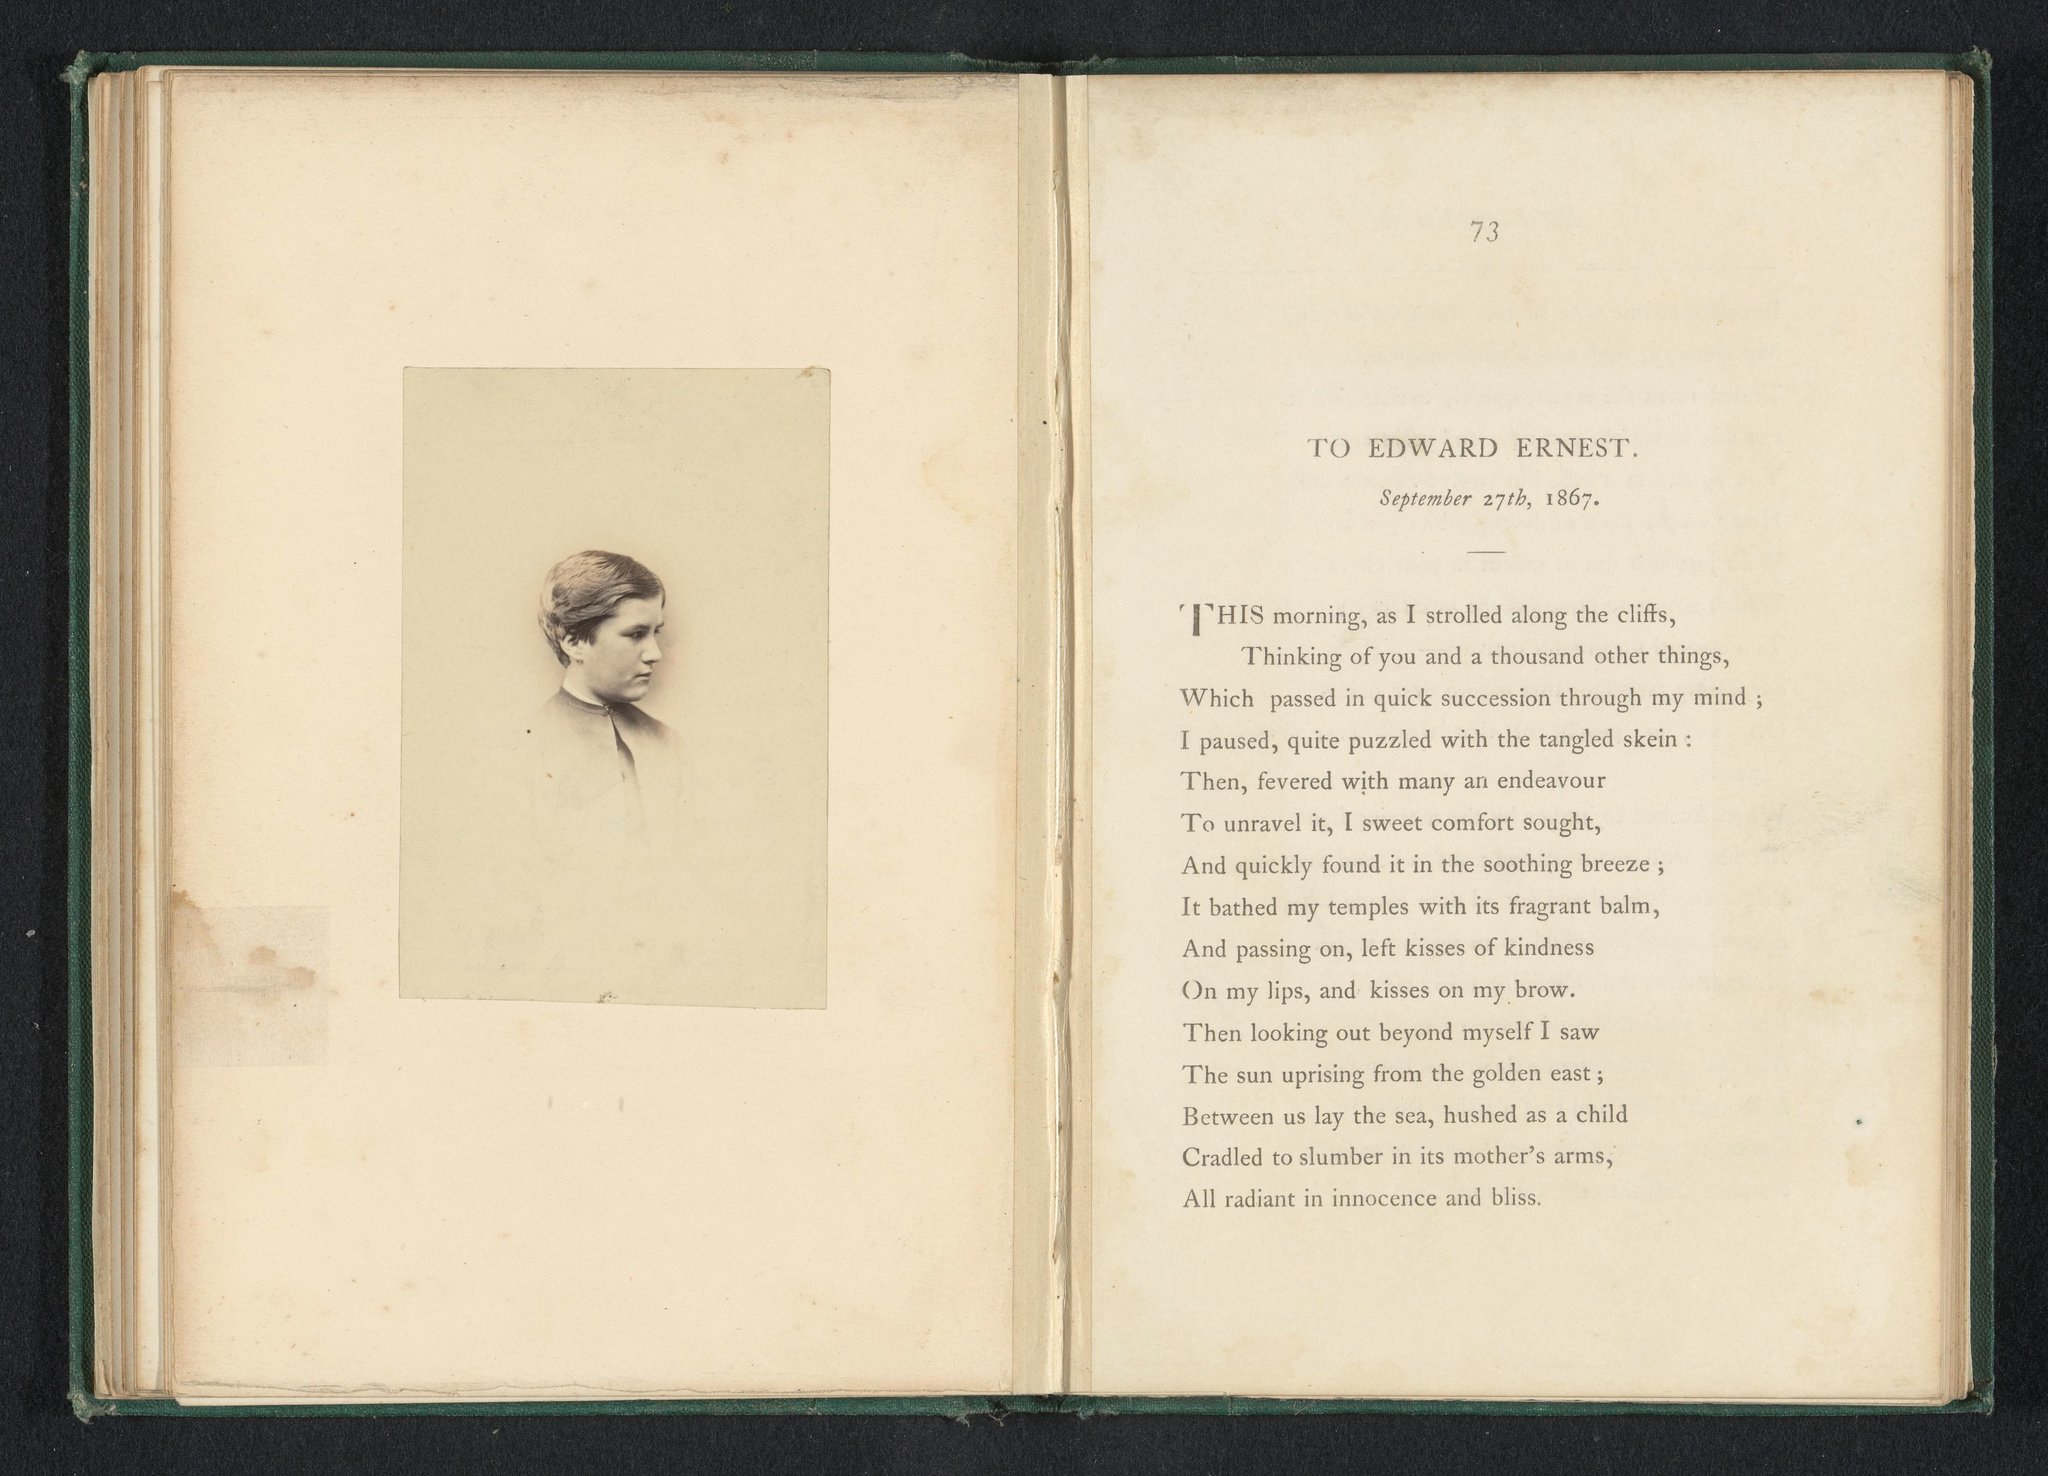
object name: photograph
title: Portret van Edward Ernest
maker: Anonymous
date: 1863-1868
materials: photographic support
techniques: albumen print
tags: boy (child between toddler and youth)